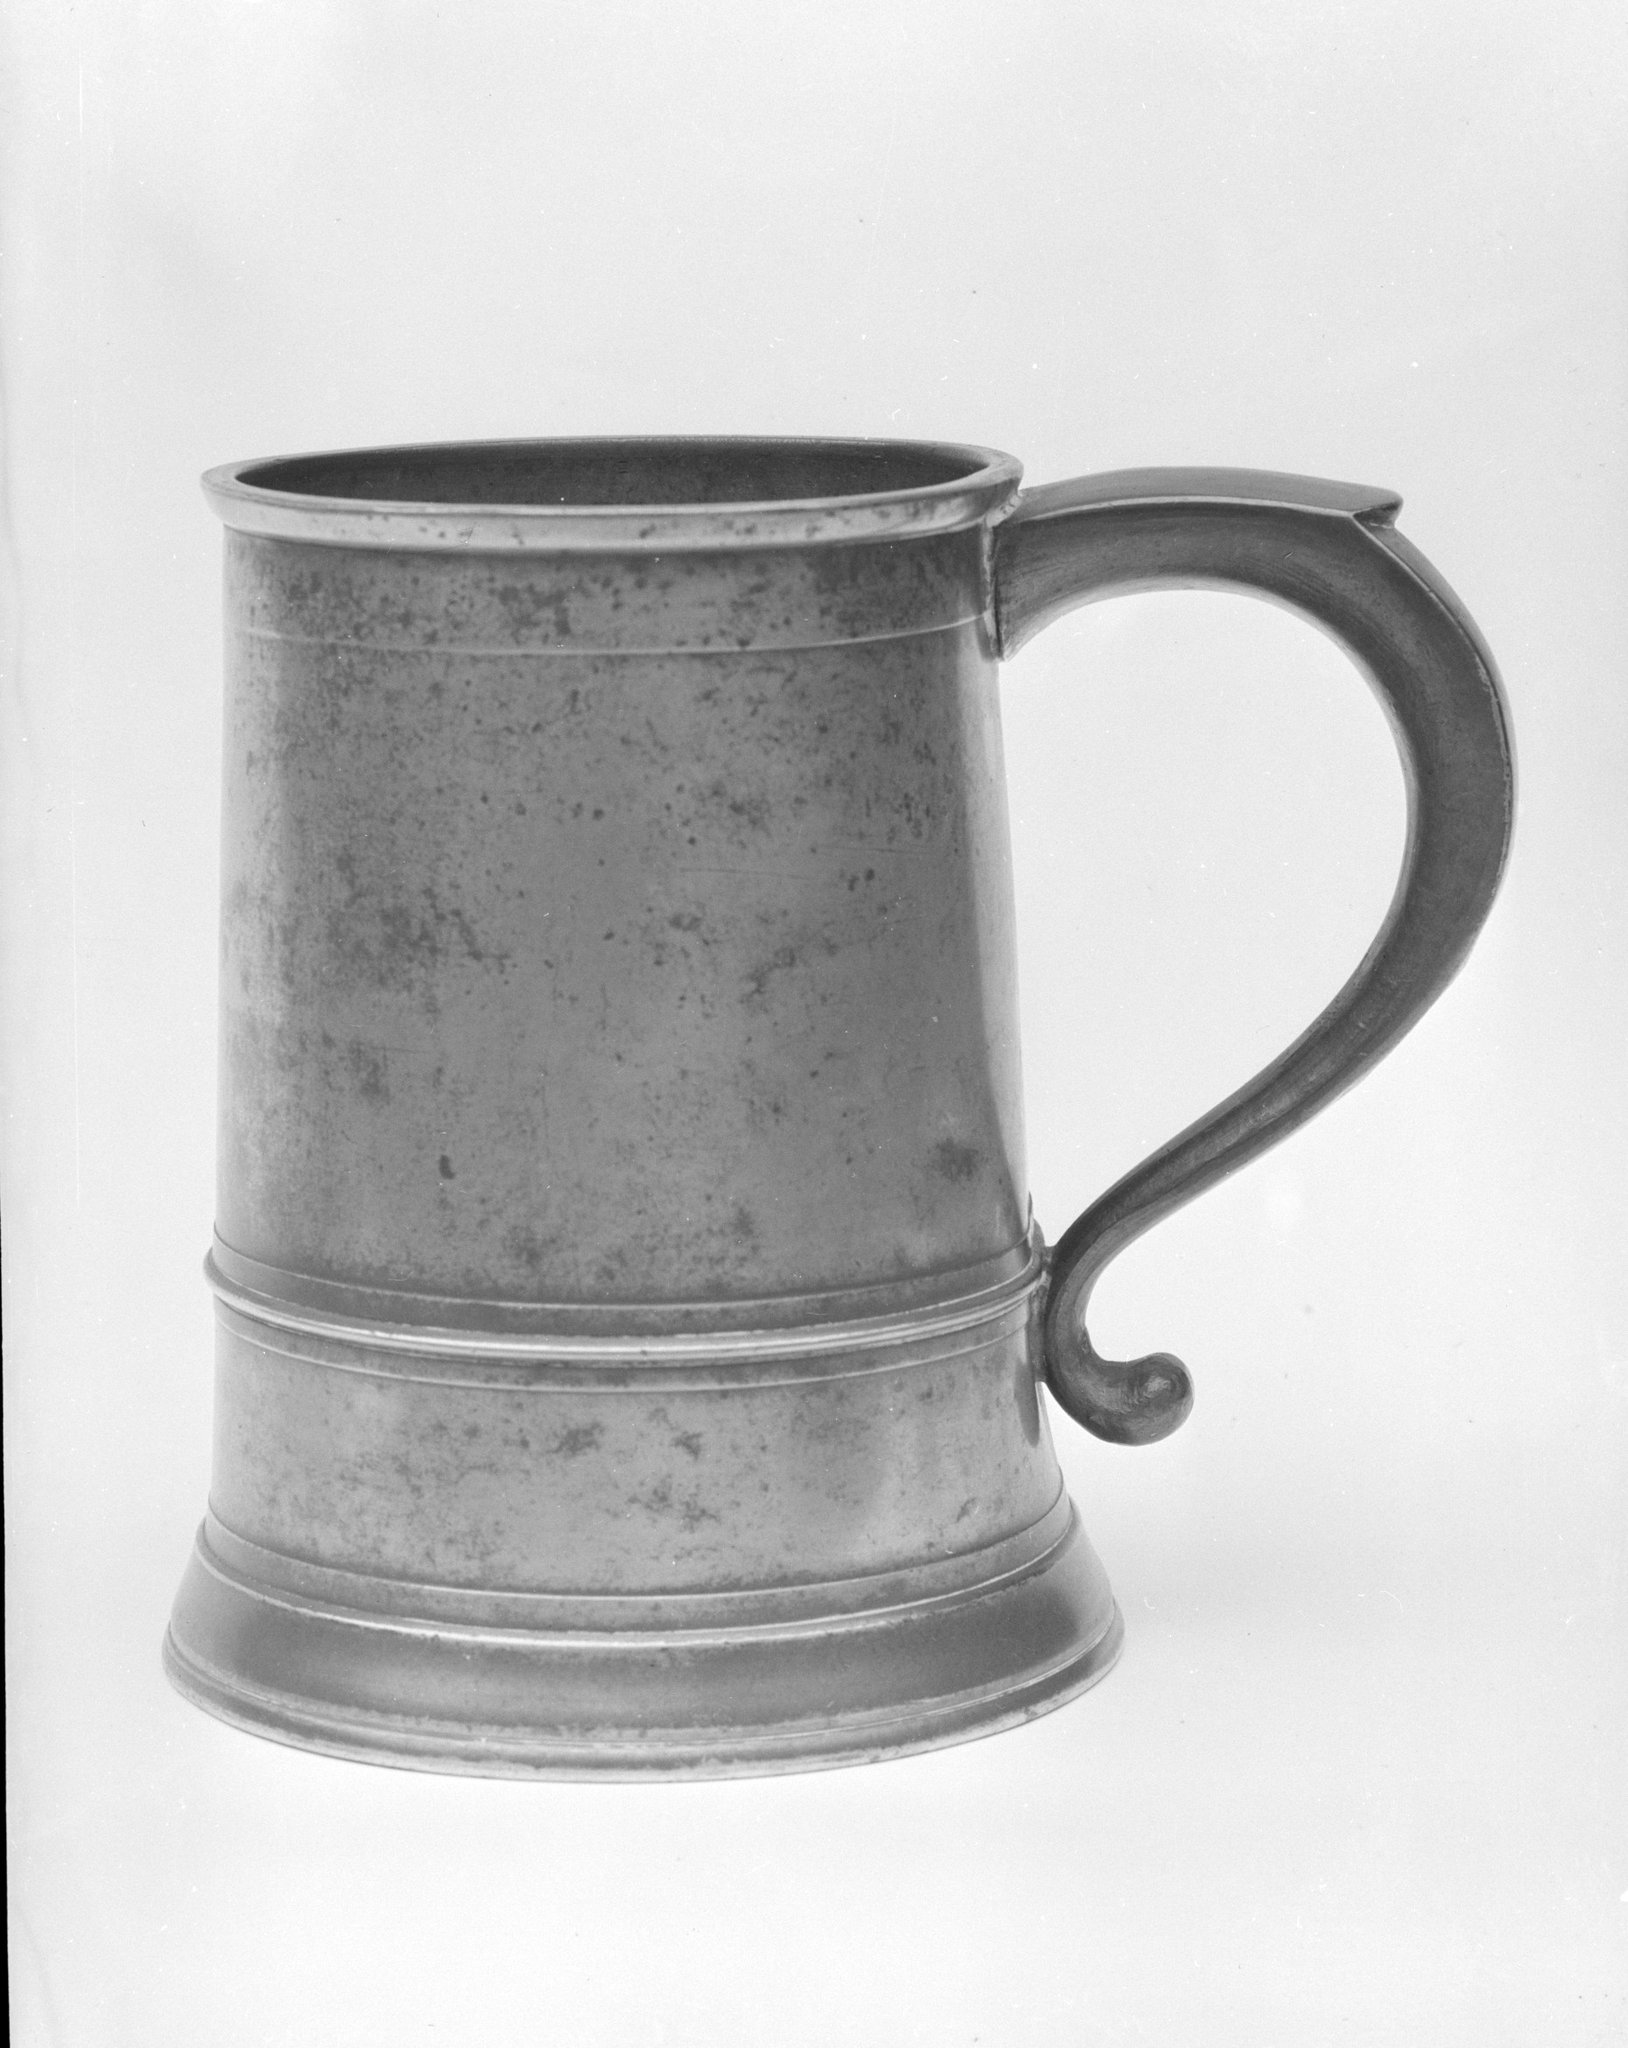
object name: mug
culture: american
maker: thomas danforth boardman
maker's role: maker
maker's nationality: american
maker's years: 1784-1873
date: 1810-1850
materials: pewter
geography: united states